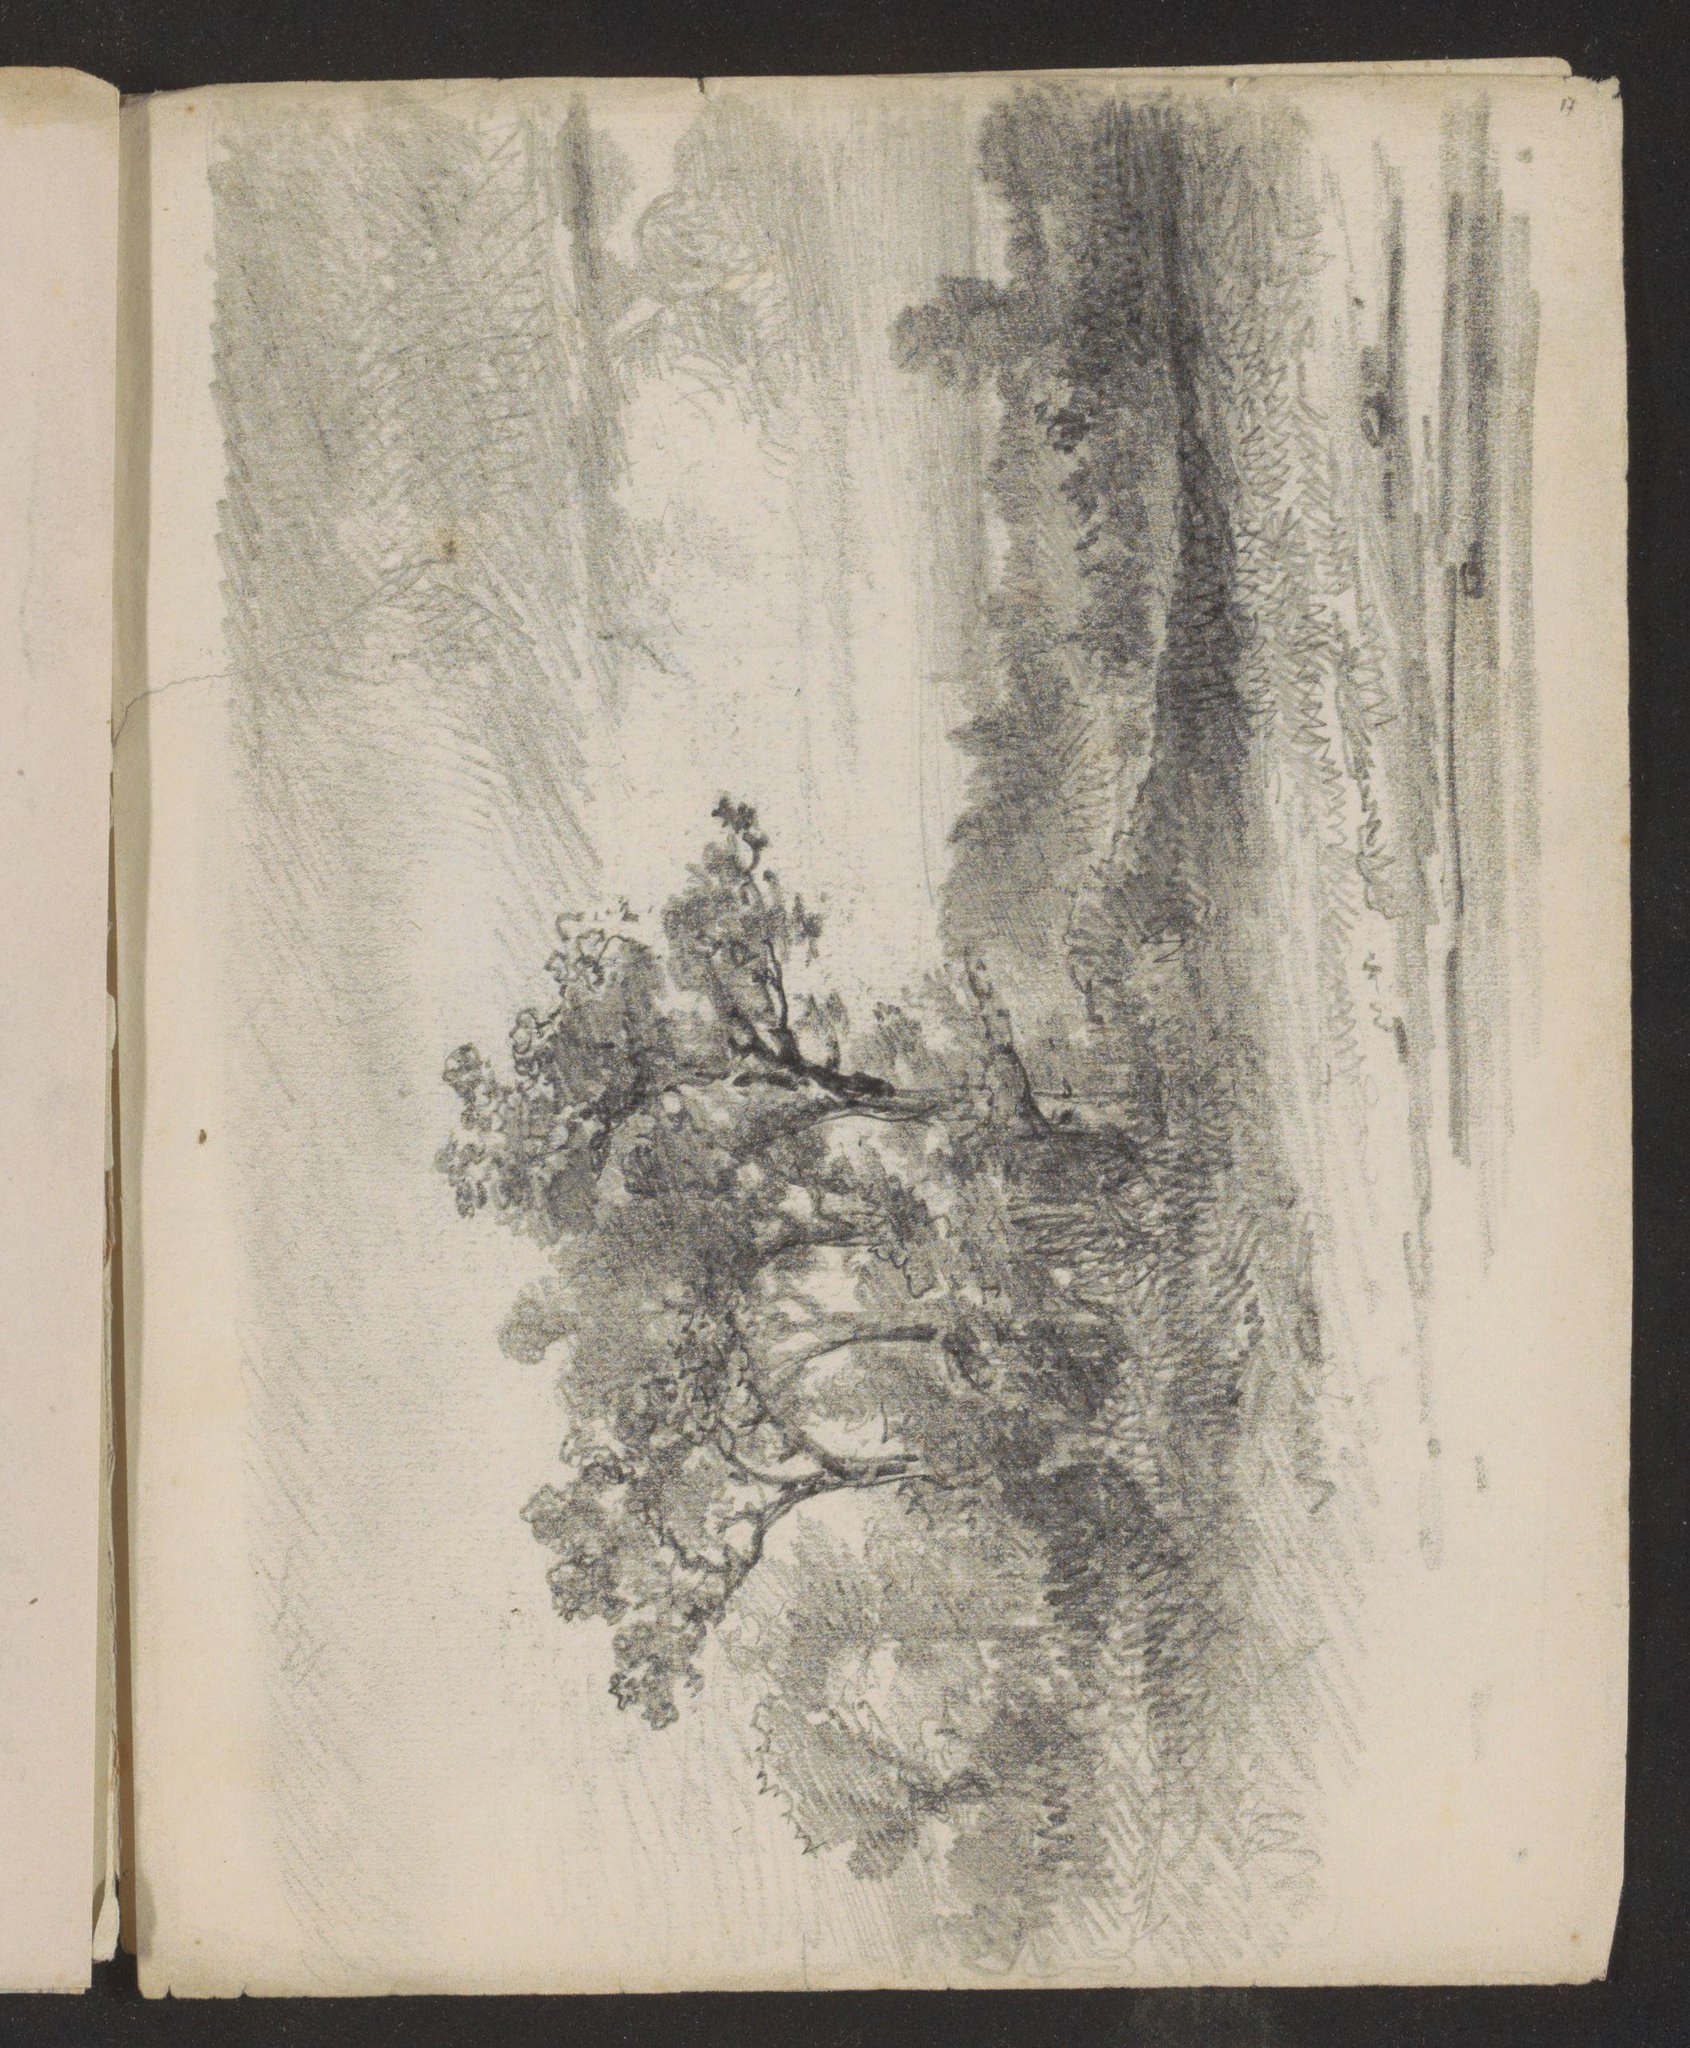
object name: sketchbook leaf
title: Landschap met bomen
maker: maria vos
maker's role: draughtsman, painter, print maker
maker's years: 1824-1906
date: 1834-1906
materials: paper, pencil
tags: landscapes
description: Blad 17 recto uit een schetsboek met 17 bladen.